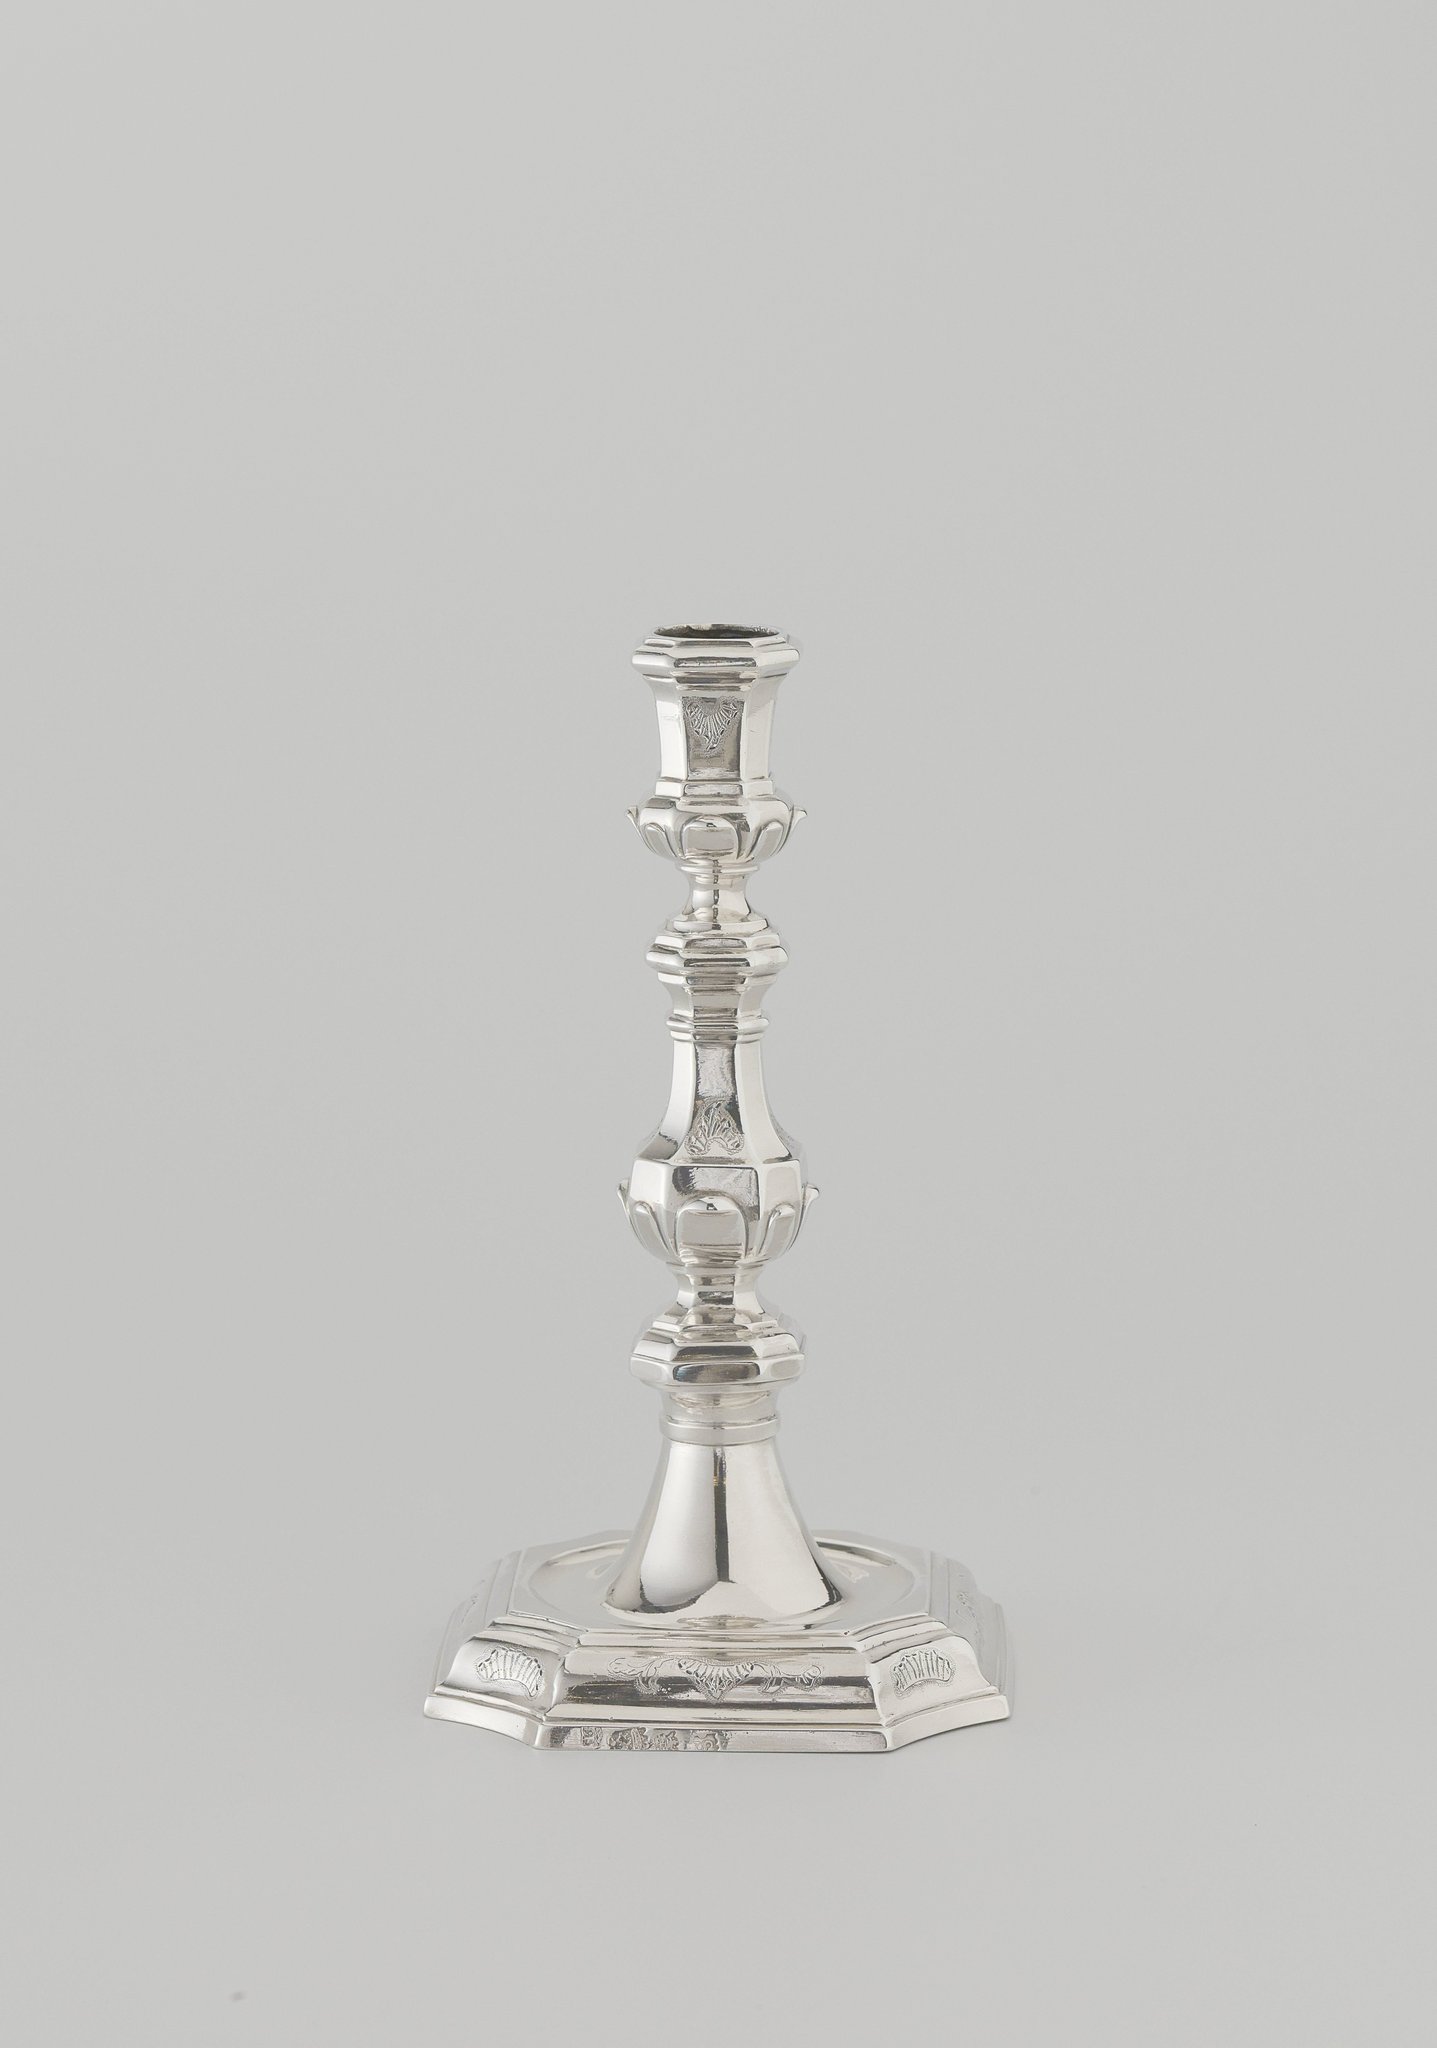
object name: candlestick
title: Kandelaar van zilver met achthoekige voet en achthoekige balustervormige stam en kaarsenhouder. Met gegraveerde rocaillemotieven.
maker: louis de haan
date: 1752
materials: silver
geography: rotterdam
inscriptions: mark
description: Kandelaar van zilver. De voet is achthoekig en in de vlakke bovenzijde bevindt zich een ronde verdieping. De balustervormige stam is achthoekig evenals de kaarsenhouder. Voet, stam en kaarsenhouder zijn gegraveerd met rocaille-motieven.